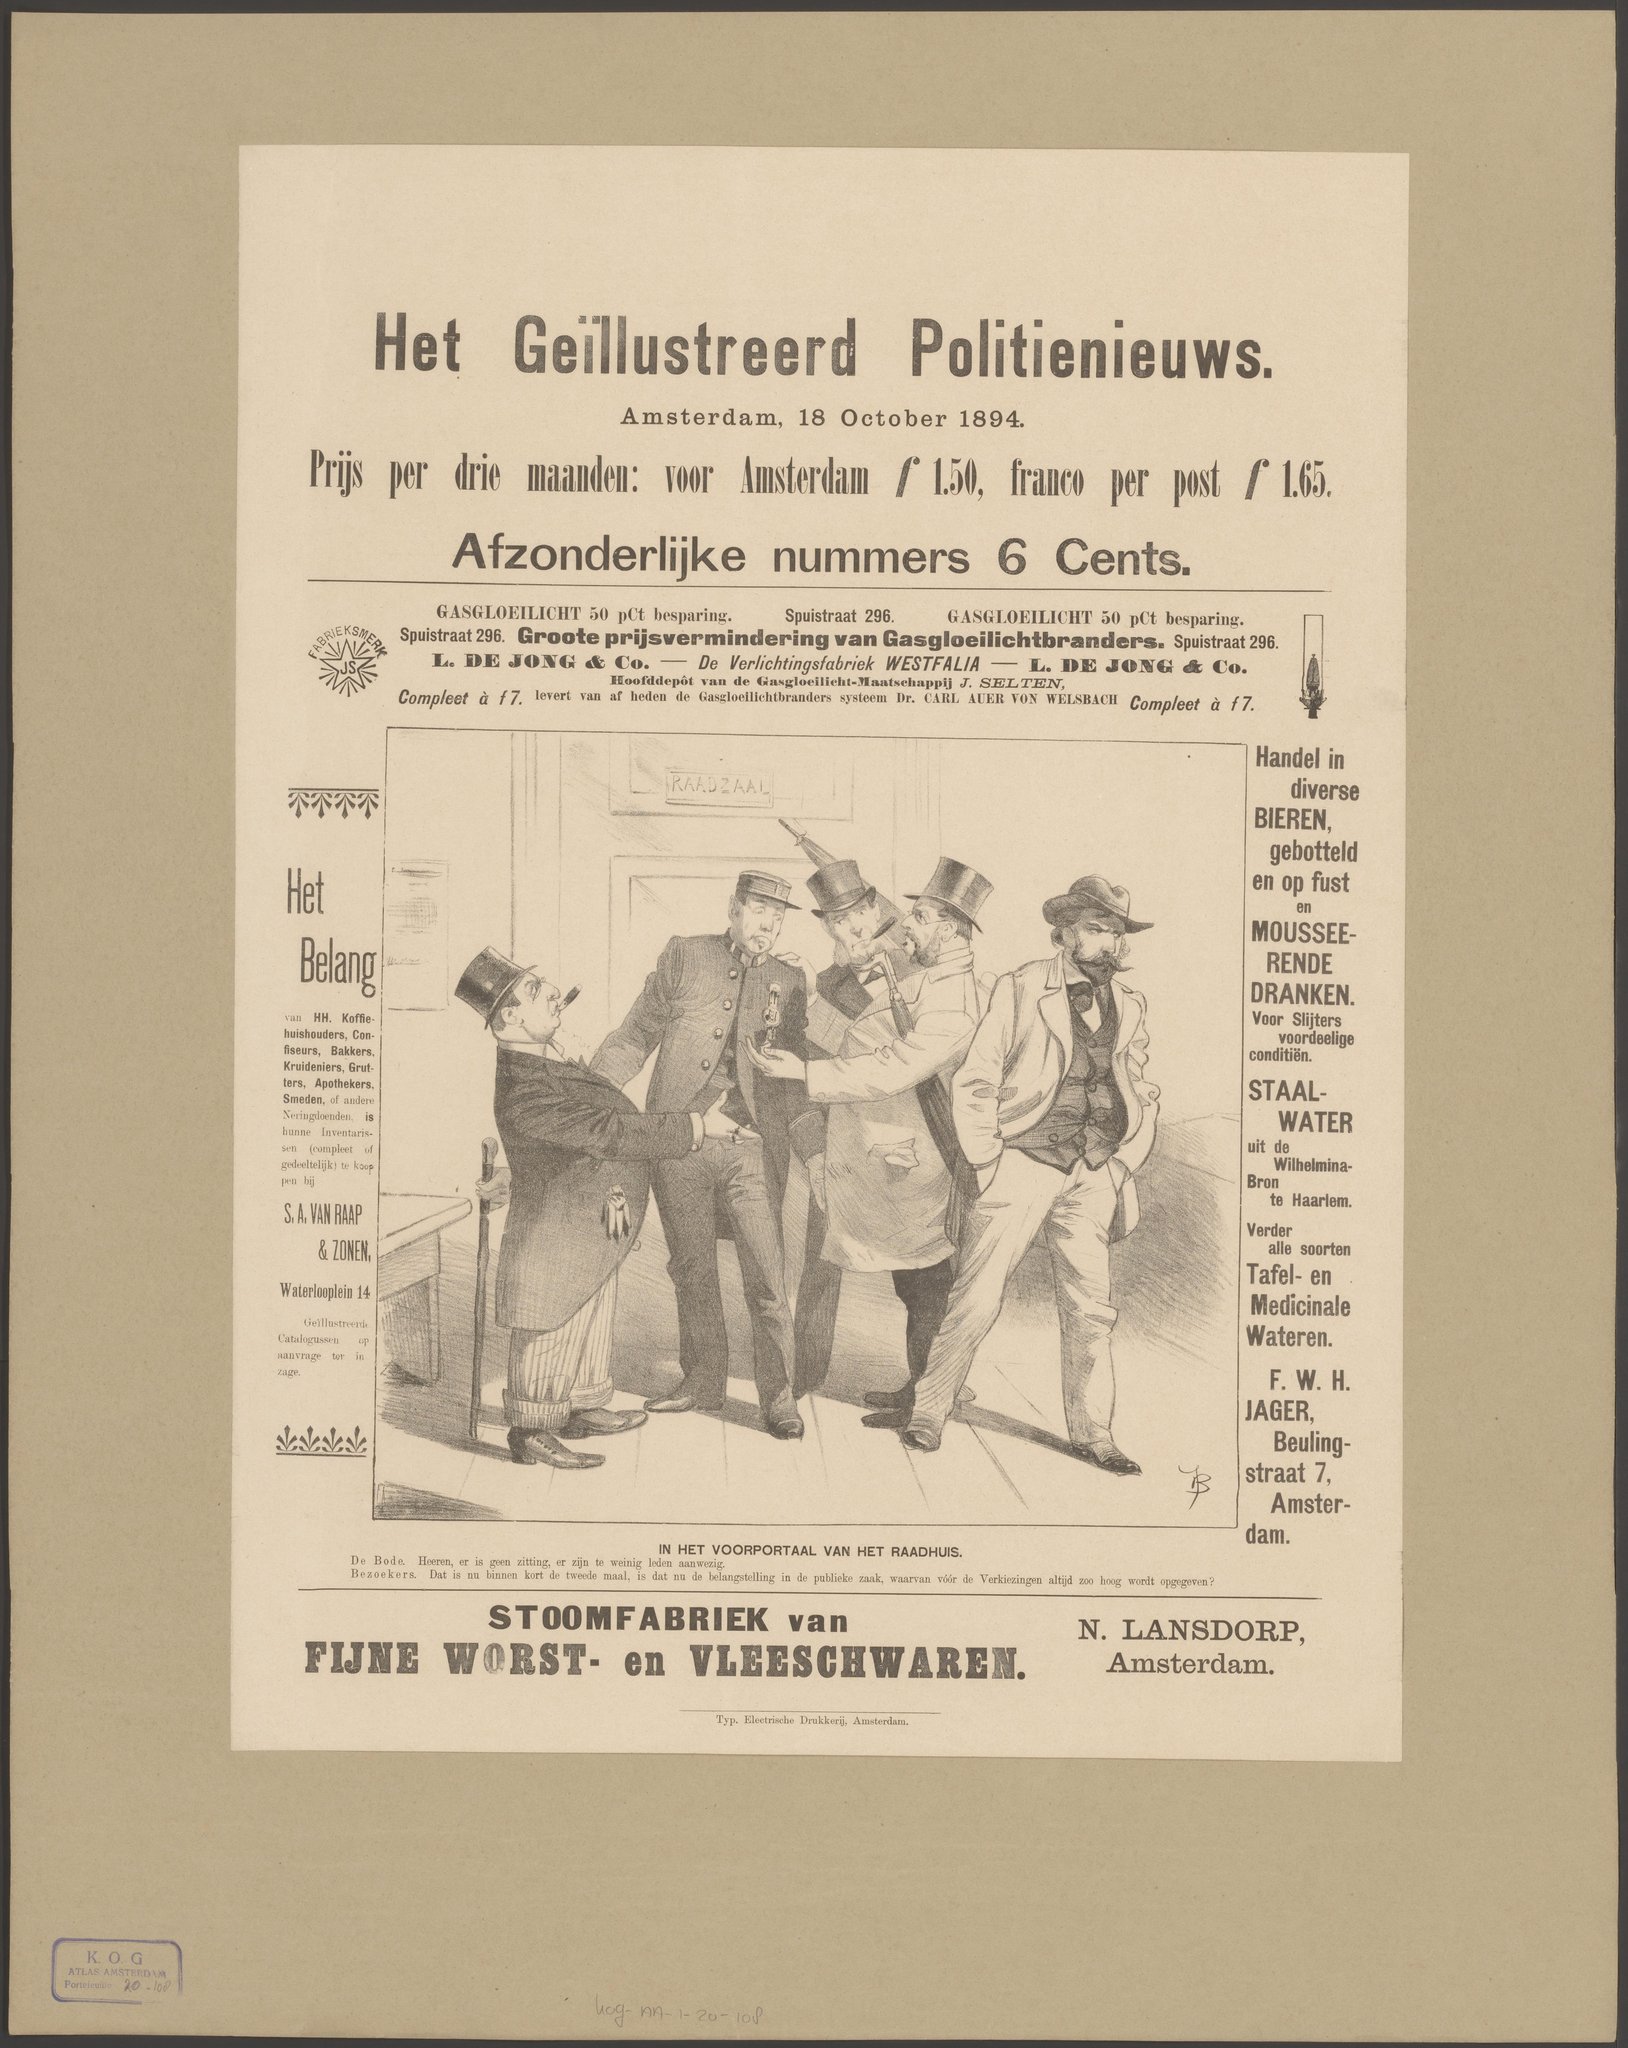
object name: cartoon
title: In het voorportaal van het raadhuis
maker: johan braakensiek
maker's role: draughtsman, print maker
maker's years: 1858-1940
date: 1894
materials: paper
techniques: letterpress printing, lithograph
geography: amsterdam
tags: townhall, debate, discussion (~ meeting), political caricatures and satires, amsterdam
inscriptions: collector's mark: Lugt 1641b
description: Gepubliceerd als bijvoegsel van 'Het Geïllustreerd Politienieuws', 18 oktober 1894.